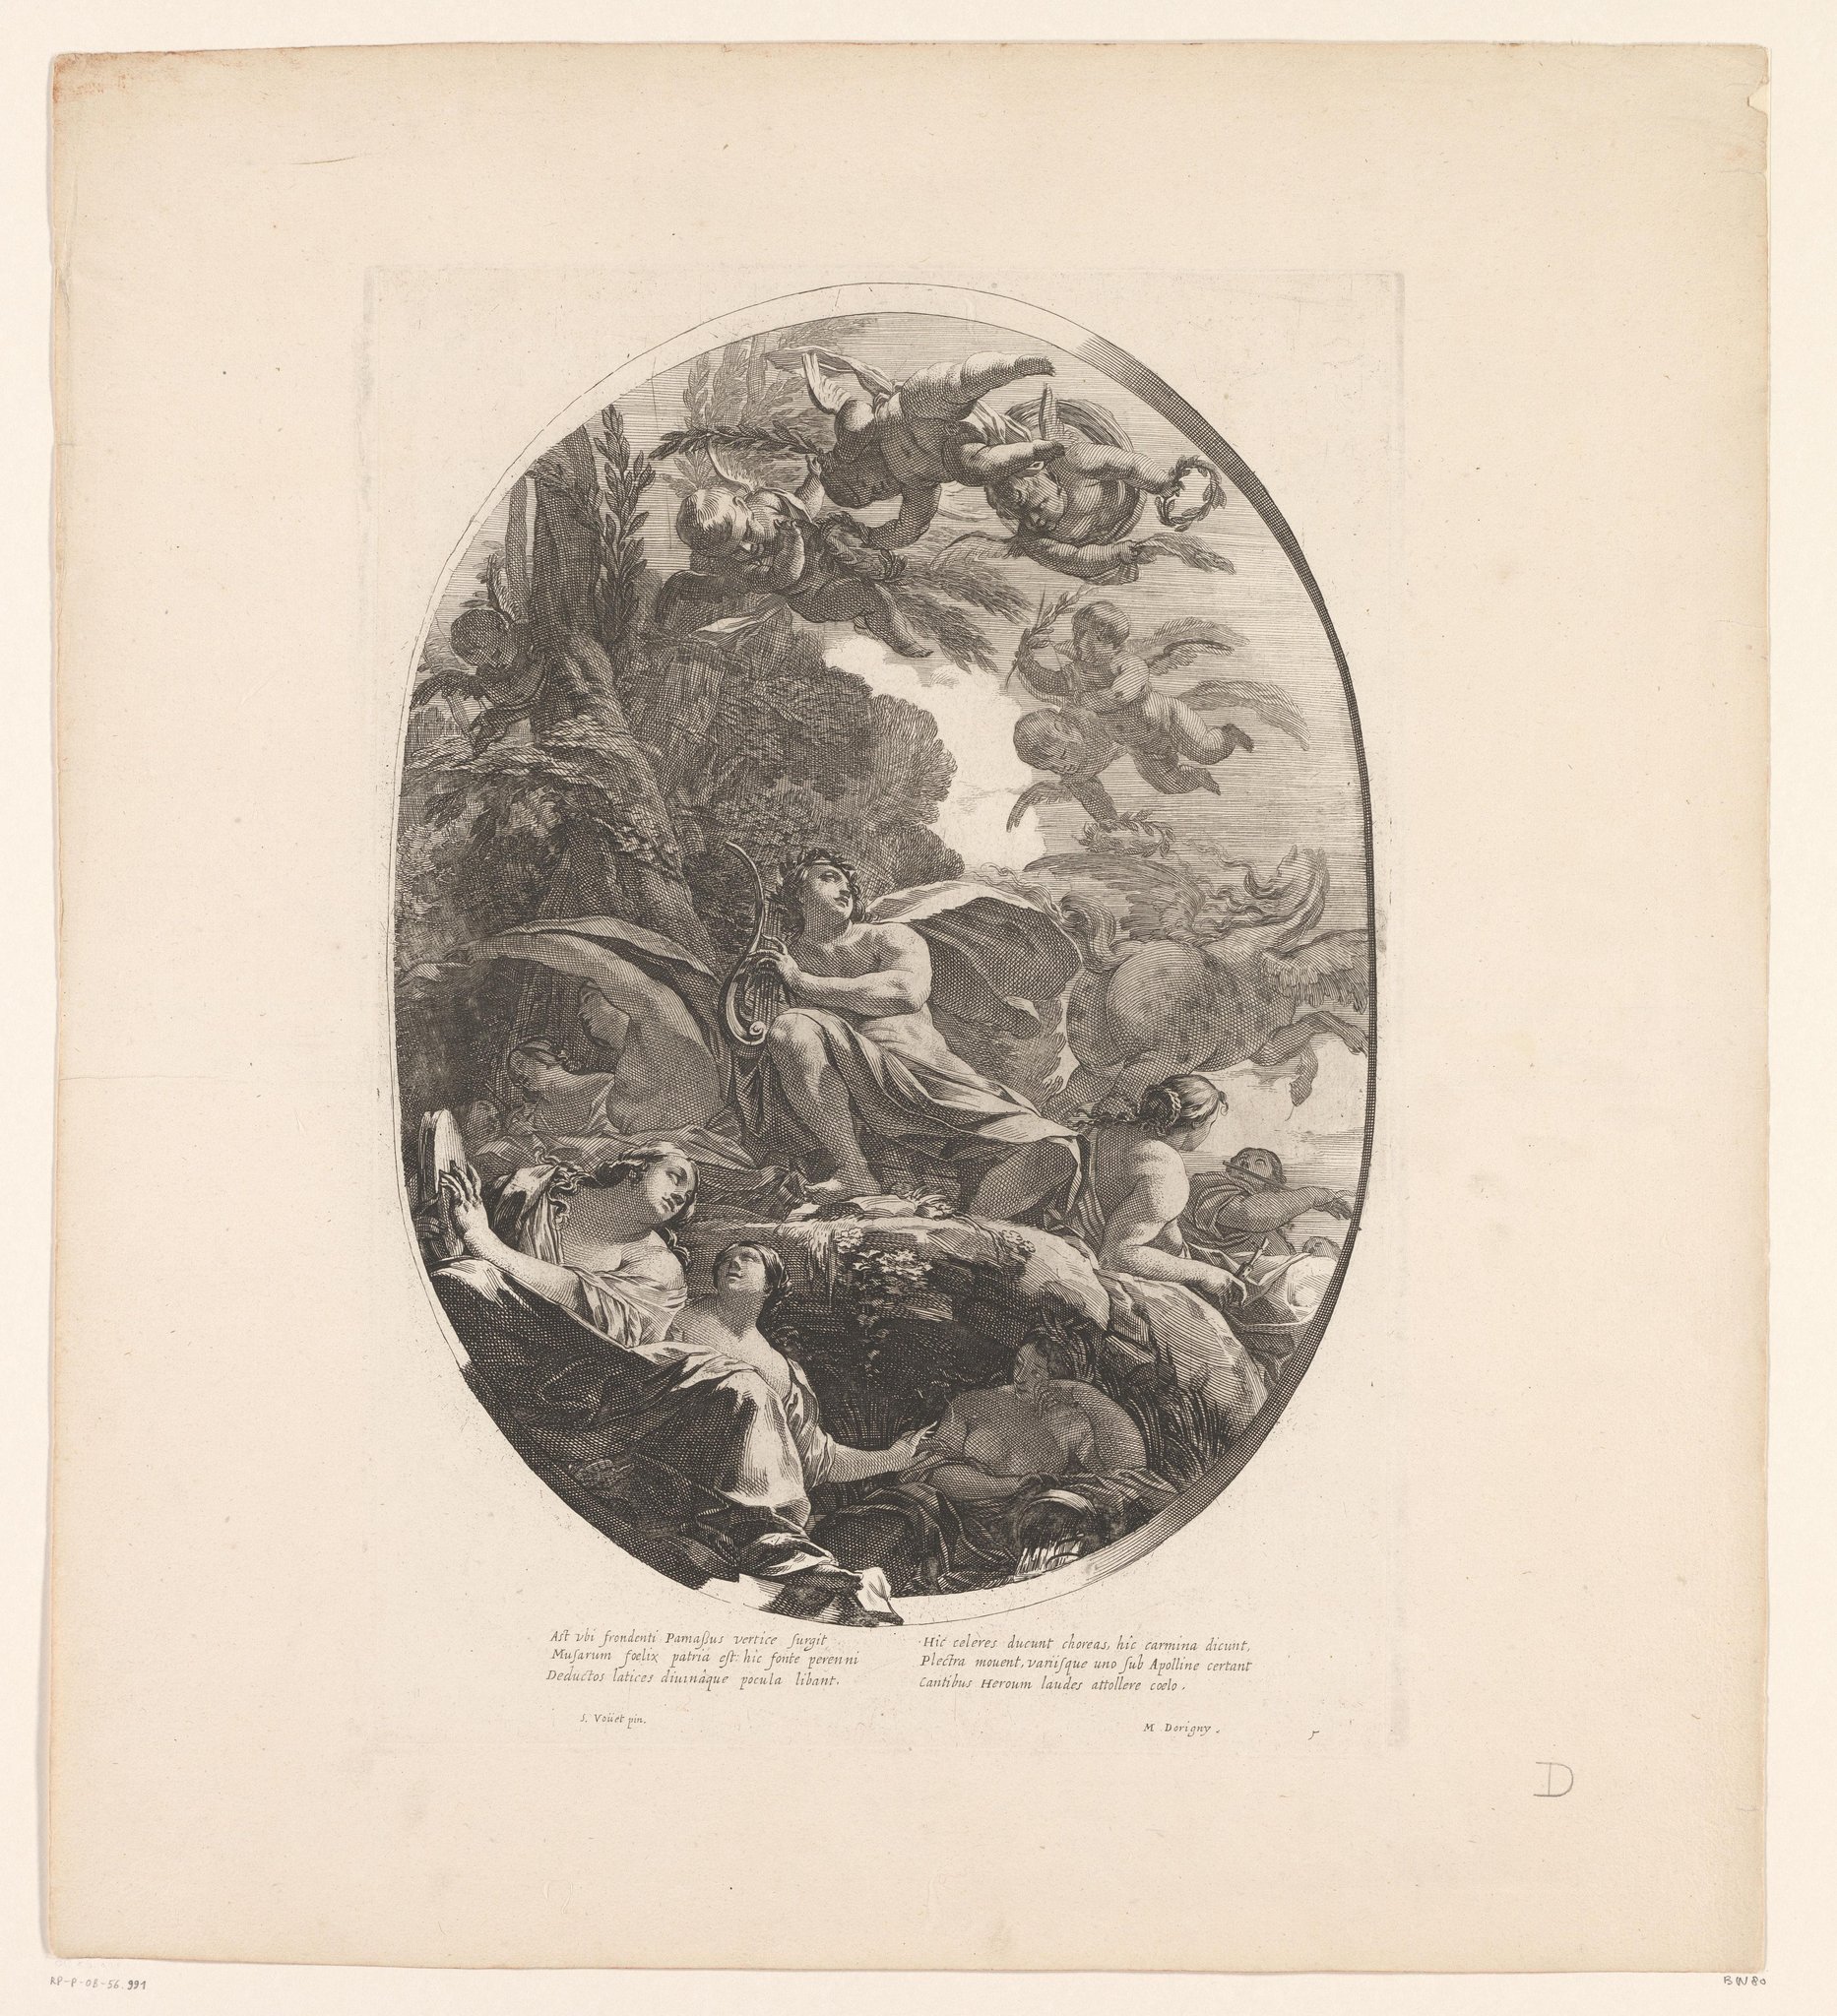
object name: print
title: Apollo met harp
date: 1640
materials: paper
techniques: engraving, etching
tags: (decorated) ceiling, attributes of apollo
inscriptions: collector's mark: Lugt 2228